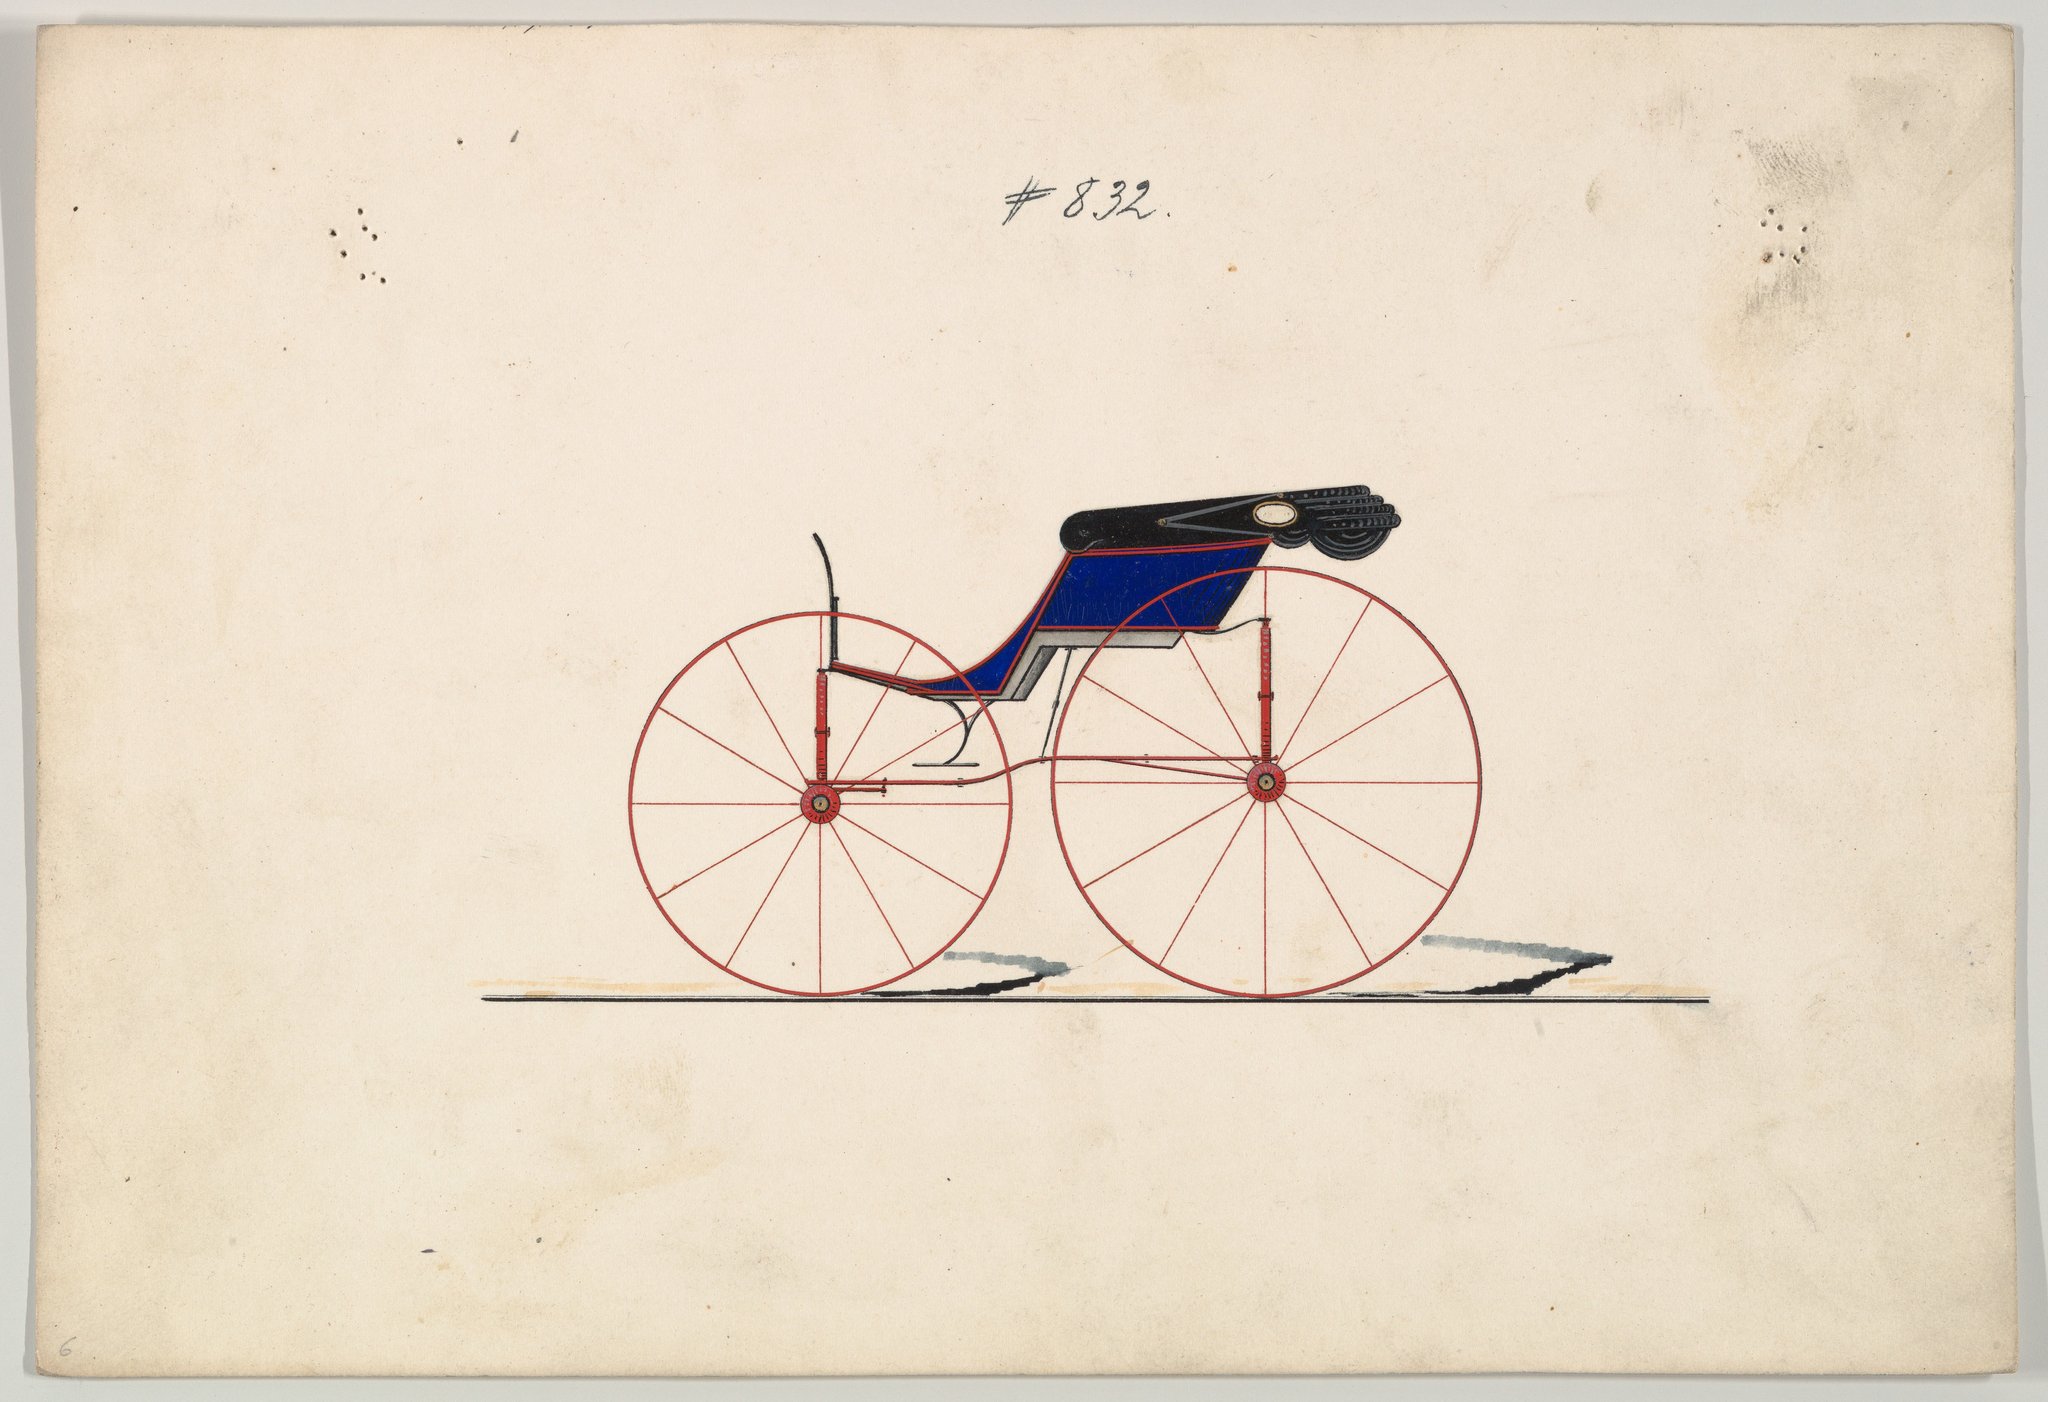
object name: drawing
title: Design for Wagon, no. 832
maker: brewster & co.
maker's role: manufacturer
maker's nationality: american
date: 1860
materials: gouache, gum arabic, watercolor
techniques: pen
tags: carriages